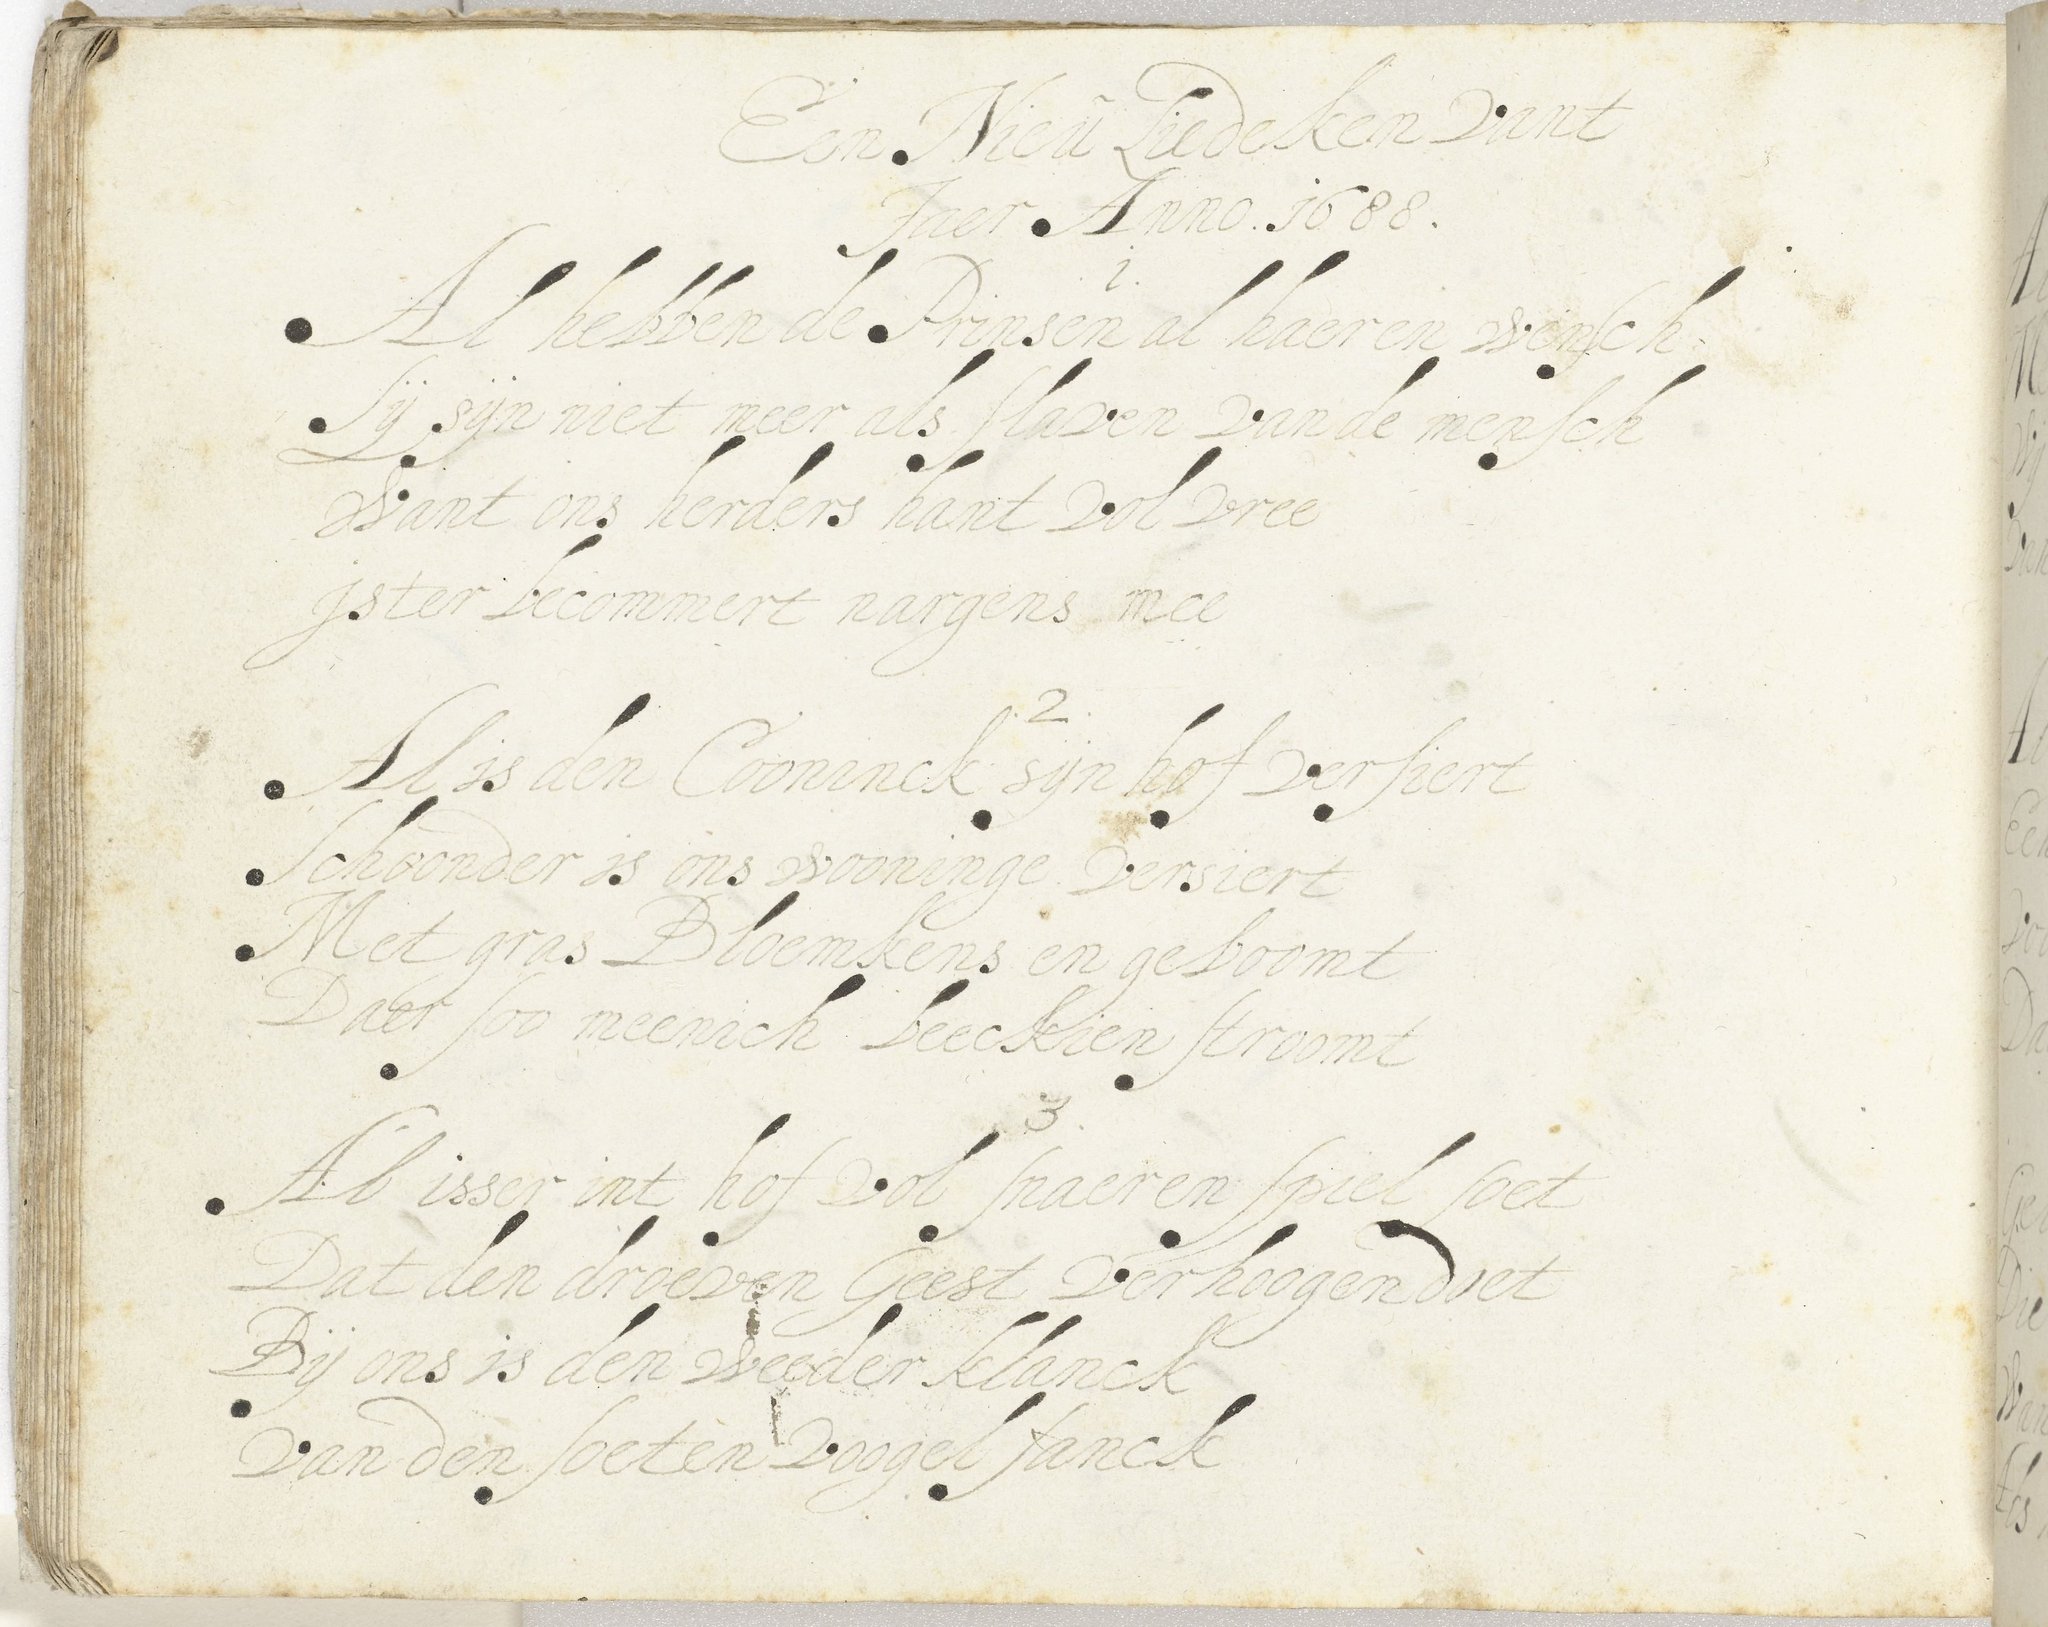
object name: poem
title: Een Nieu liedeken van Jaer Anno.1688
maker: gesina ter borch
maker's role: draughtsman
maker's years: 1633-1690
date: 1650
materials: ink, paper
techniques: calligraphy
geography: zwolle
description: Gedicht over het contrast tussen de luxe aan het hof en de eenvoud van het herdersleven. Gedicht op de melodie van Een Nieu liedeken van Jaer Anno 1588 (Gesina lijkt per ongeluk 1688 geschreven te hebben in plaats van 1588, wat de datum was van de melodie die ze wilde aangeven).